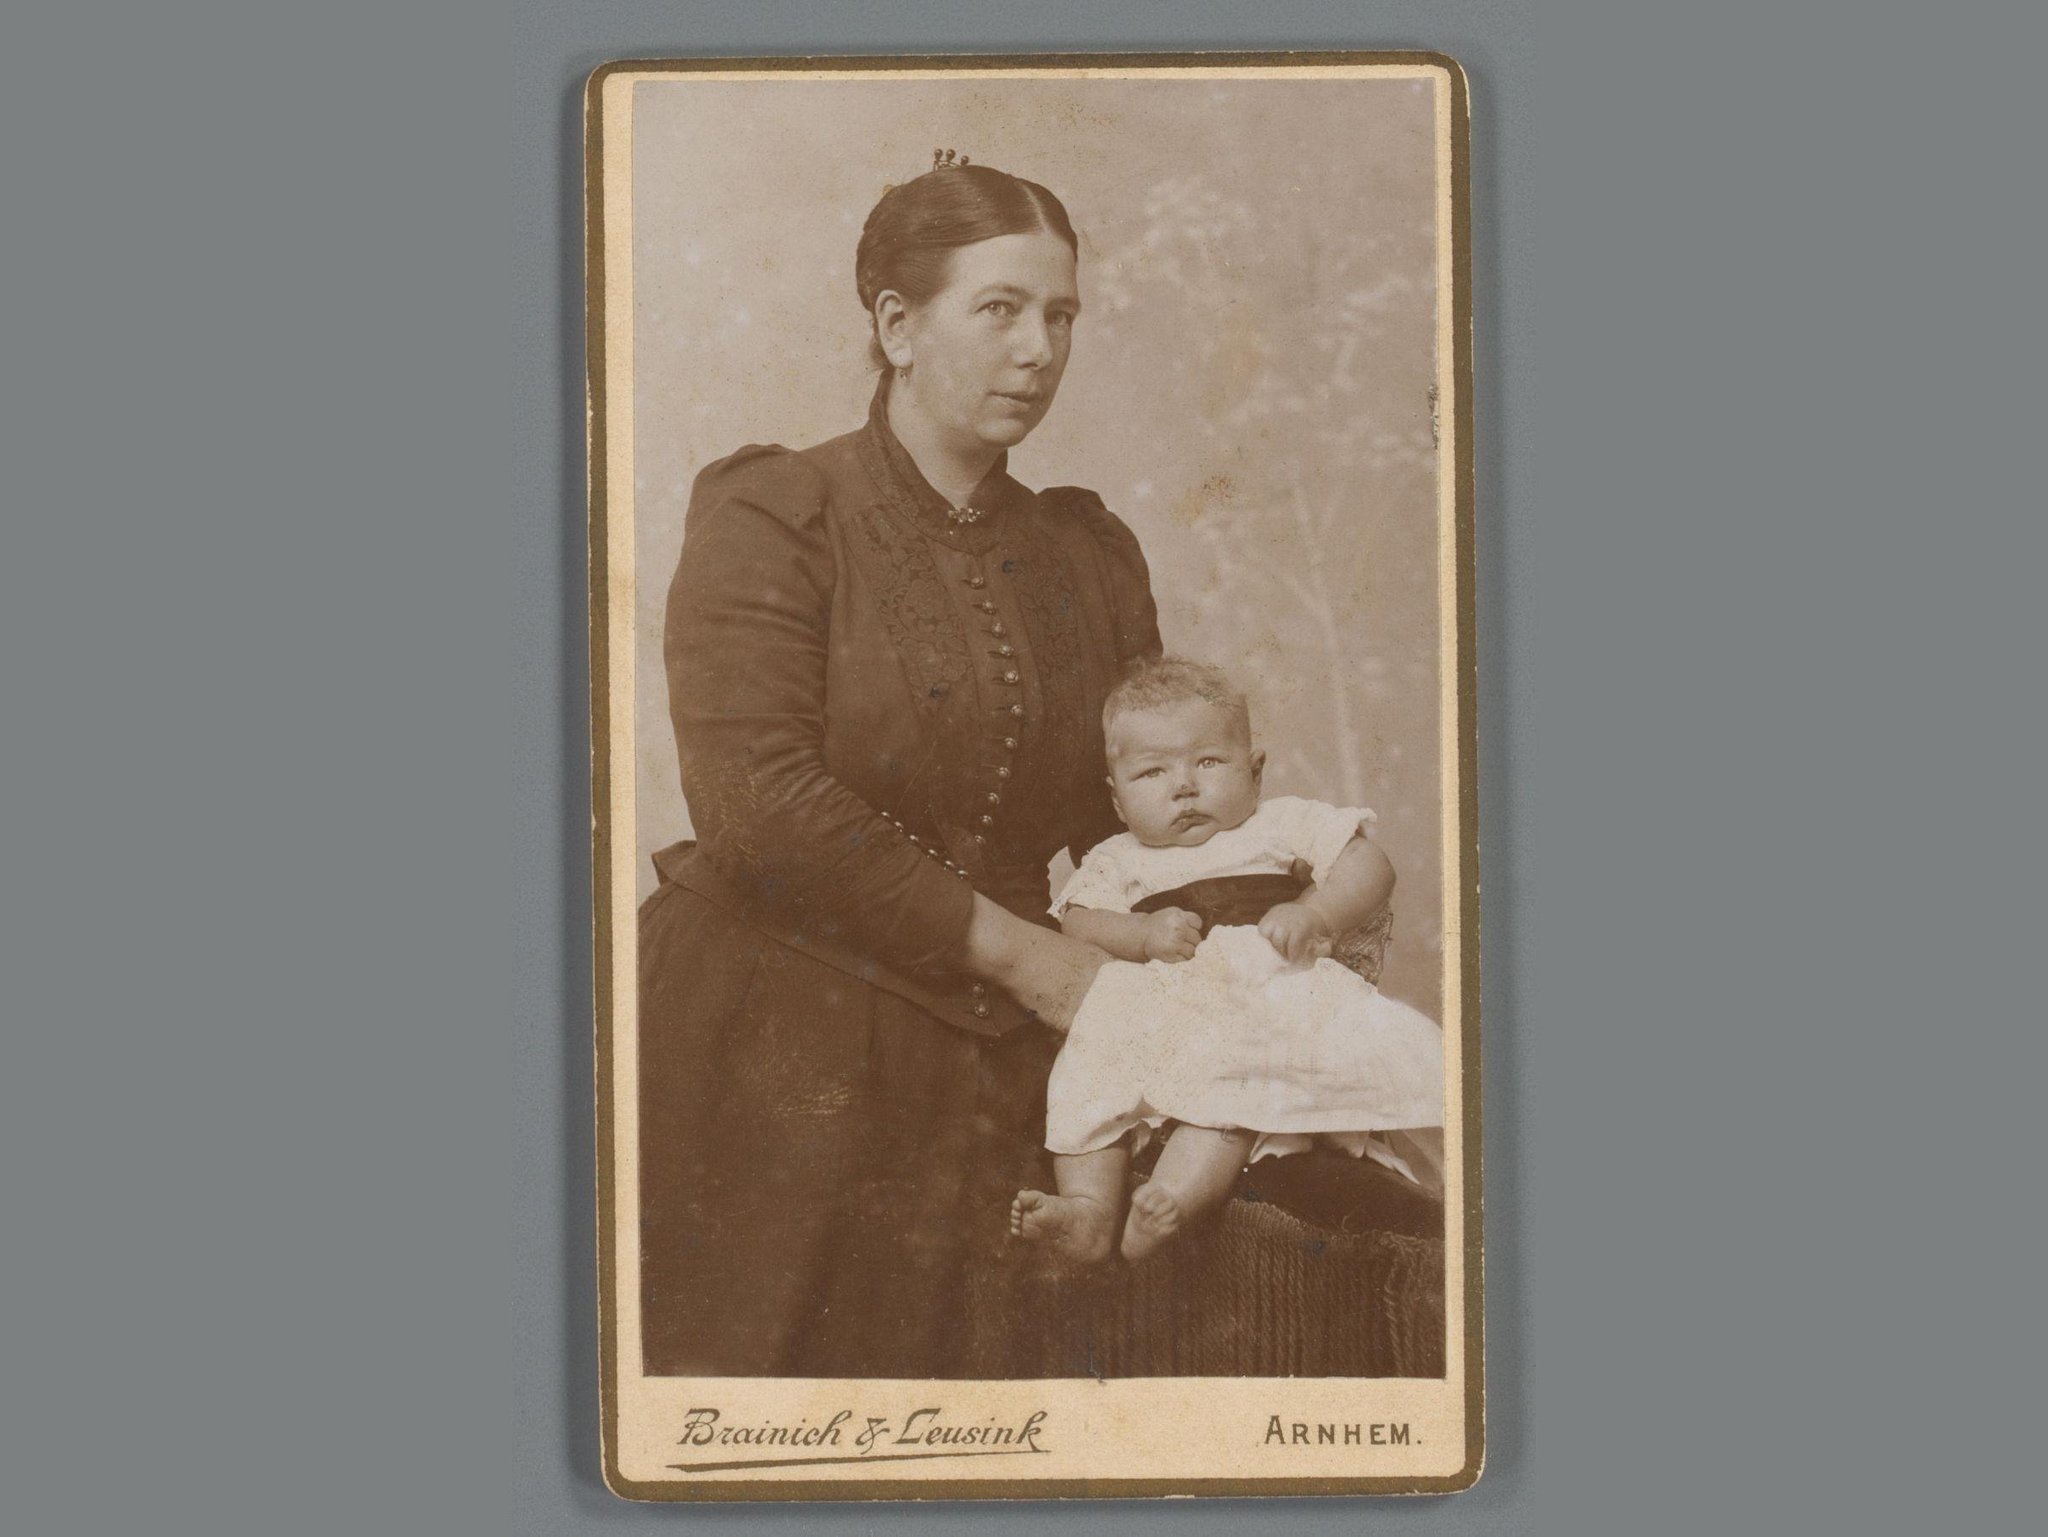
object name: carte de visite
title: Portret van een onbekende vrouw met een kind uit de familie en de kring van Eugene van Delden en Belle van Delden-Denninghof Stelling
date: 1861-1887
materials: paper, cardboard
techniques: collodion silver print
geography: arnhem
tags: historical persons not known by name - bb - woman, mother and baby or young child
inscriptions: inscription: ‘Photographisch/ Atelier/ van/ BRAINICH & LEUSINK/ Menthensteeg No. 7/ ARNHEM/ De platen blijven voor nabestelling bewaard, ook worden/ vergrootingen naar ieder klein portret vervaardigd.’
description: Portret uit de kring van Eugene van Delden (Hartapoera, 1865 - Den Haag, 1954) en Belle van Delden-Denninghof Stelling (Batavia, 1870 - Den Haag, 1947).